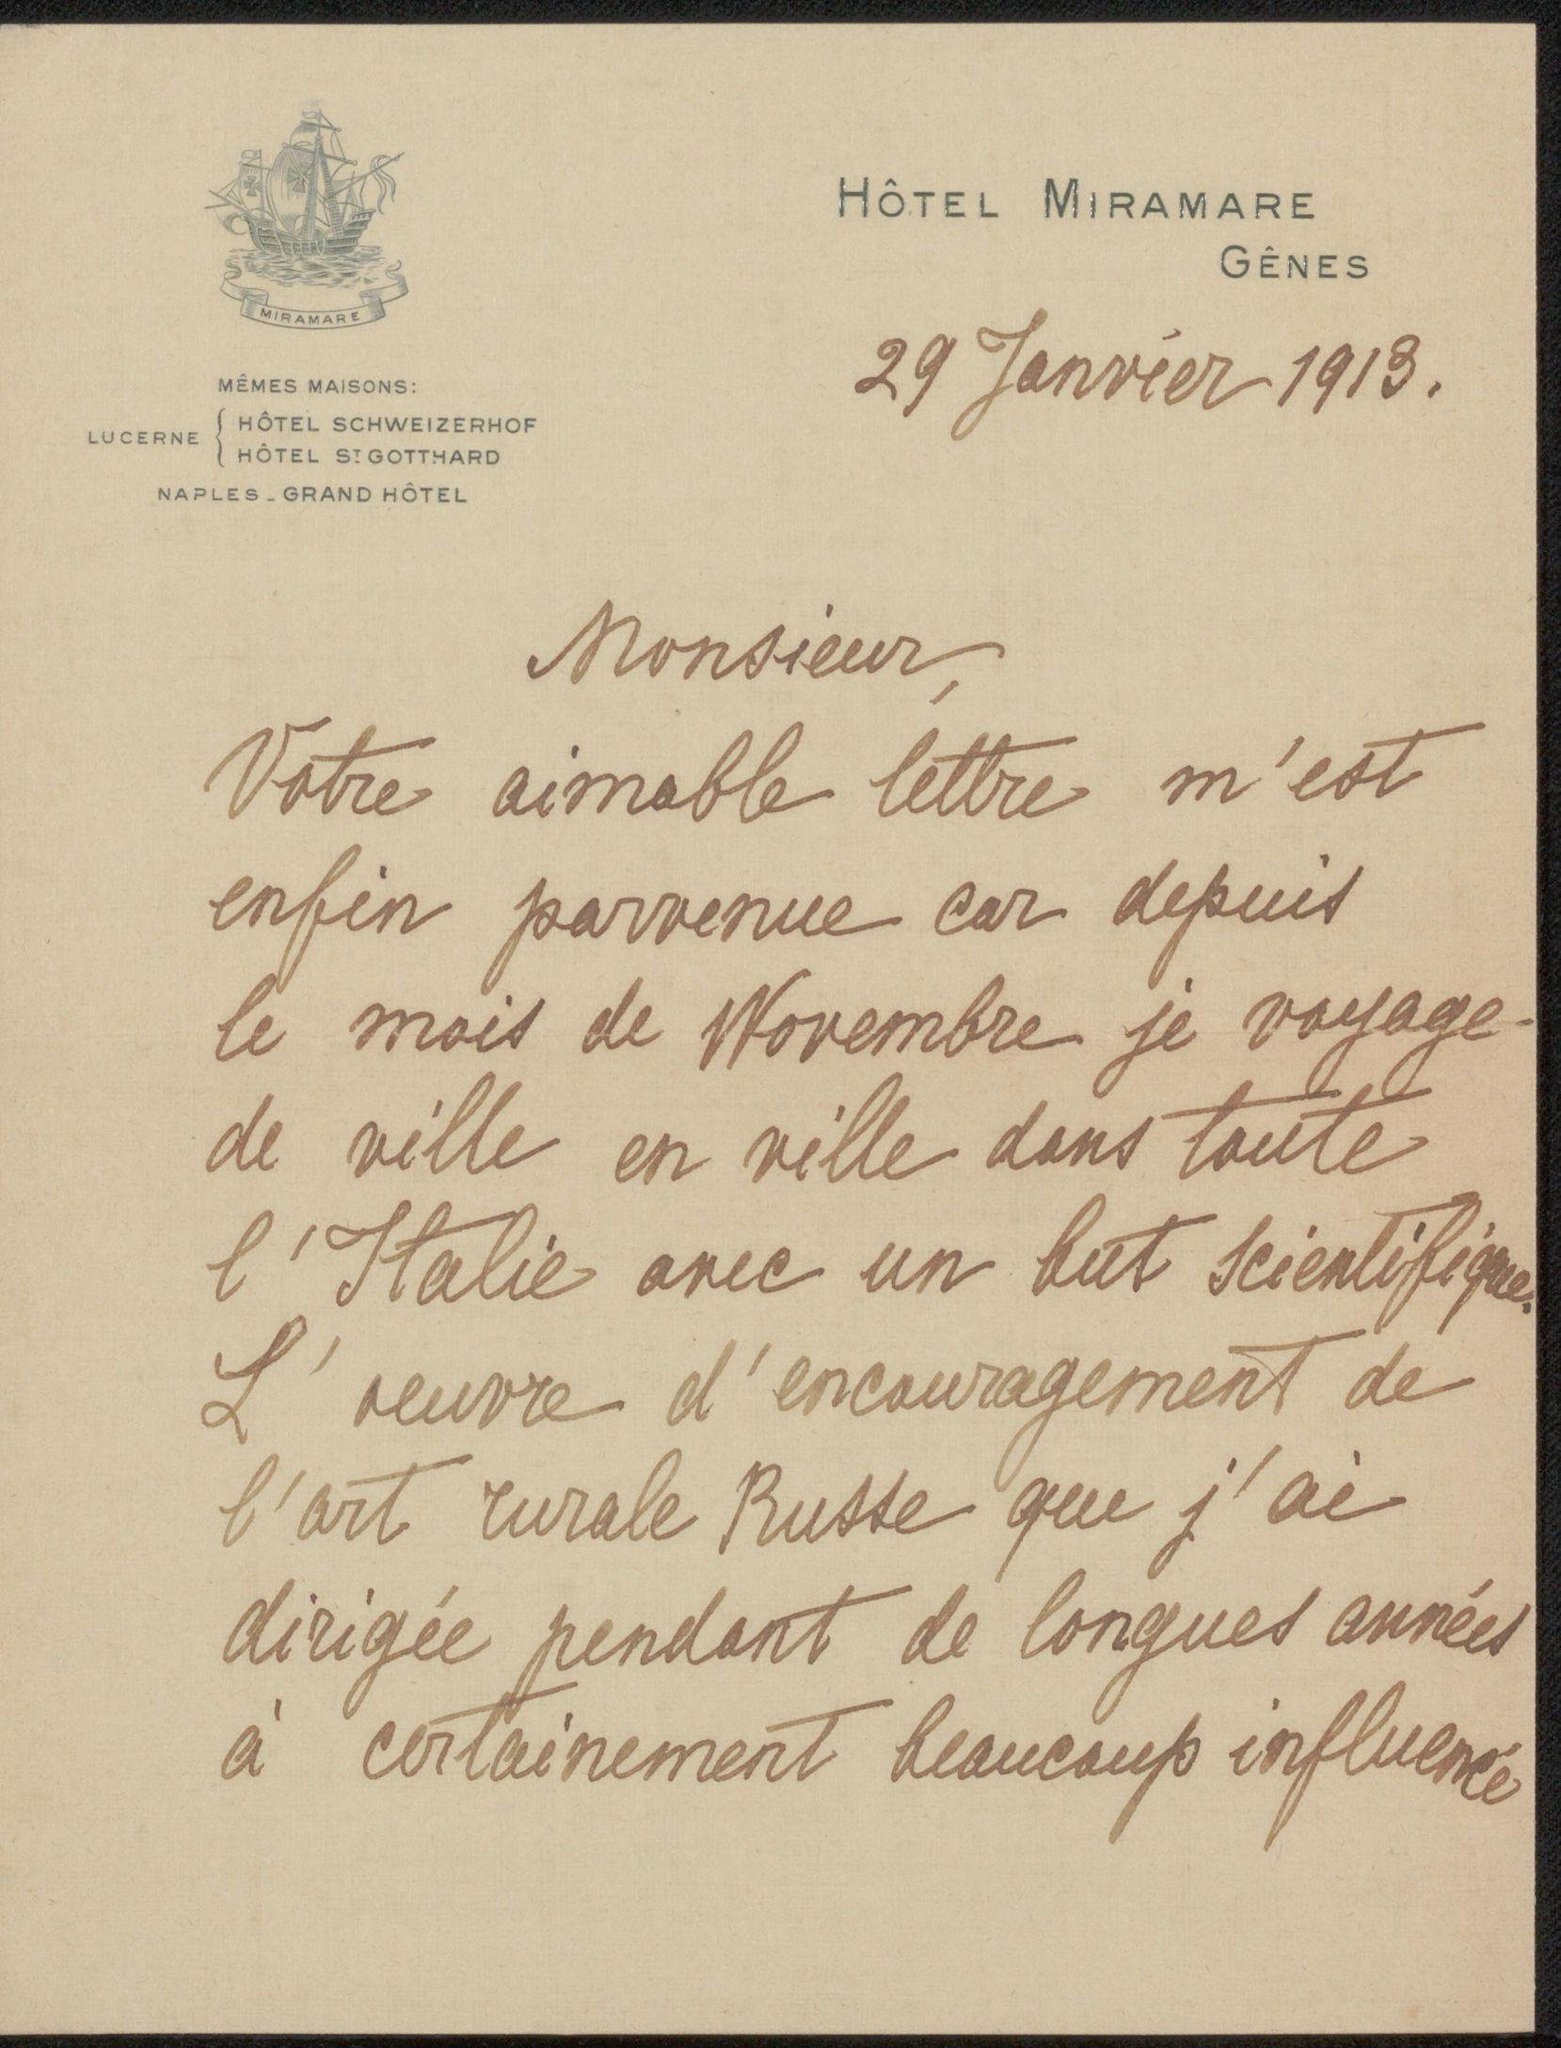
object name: letter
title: Brief aan Philip Zilcken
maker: marie zénicheff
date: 1913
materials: ink, paper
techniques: pen, printing, writing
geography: genoa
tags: painter, draughtsman, philip zilcken, applied arts, arts and crafts; industrial design, exhibition ~ art, italy, russia, london, brussels, prague, paris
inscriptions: collector's mark: ‘RPK’